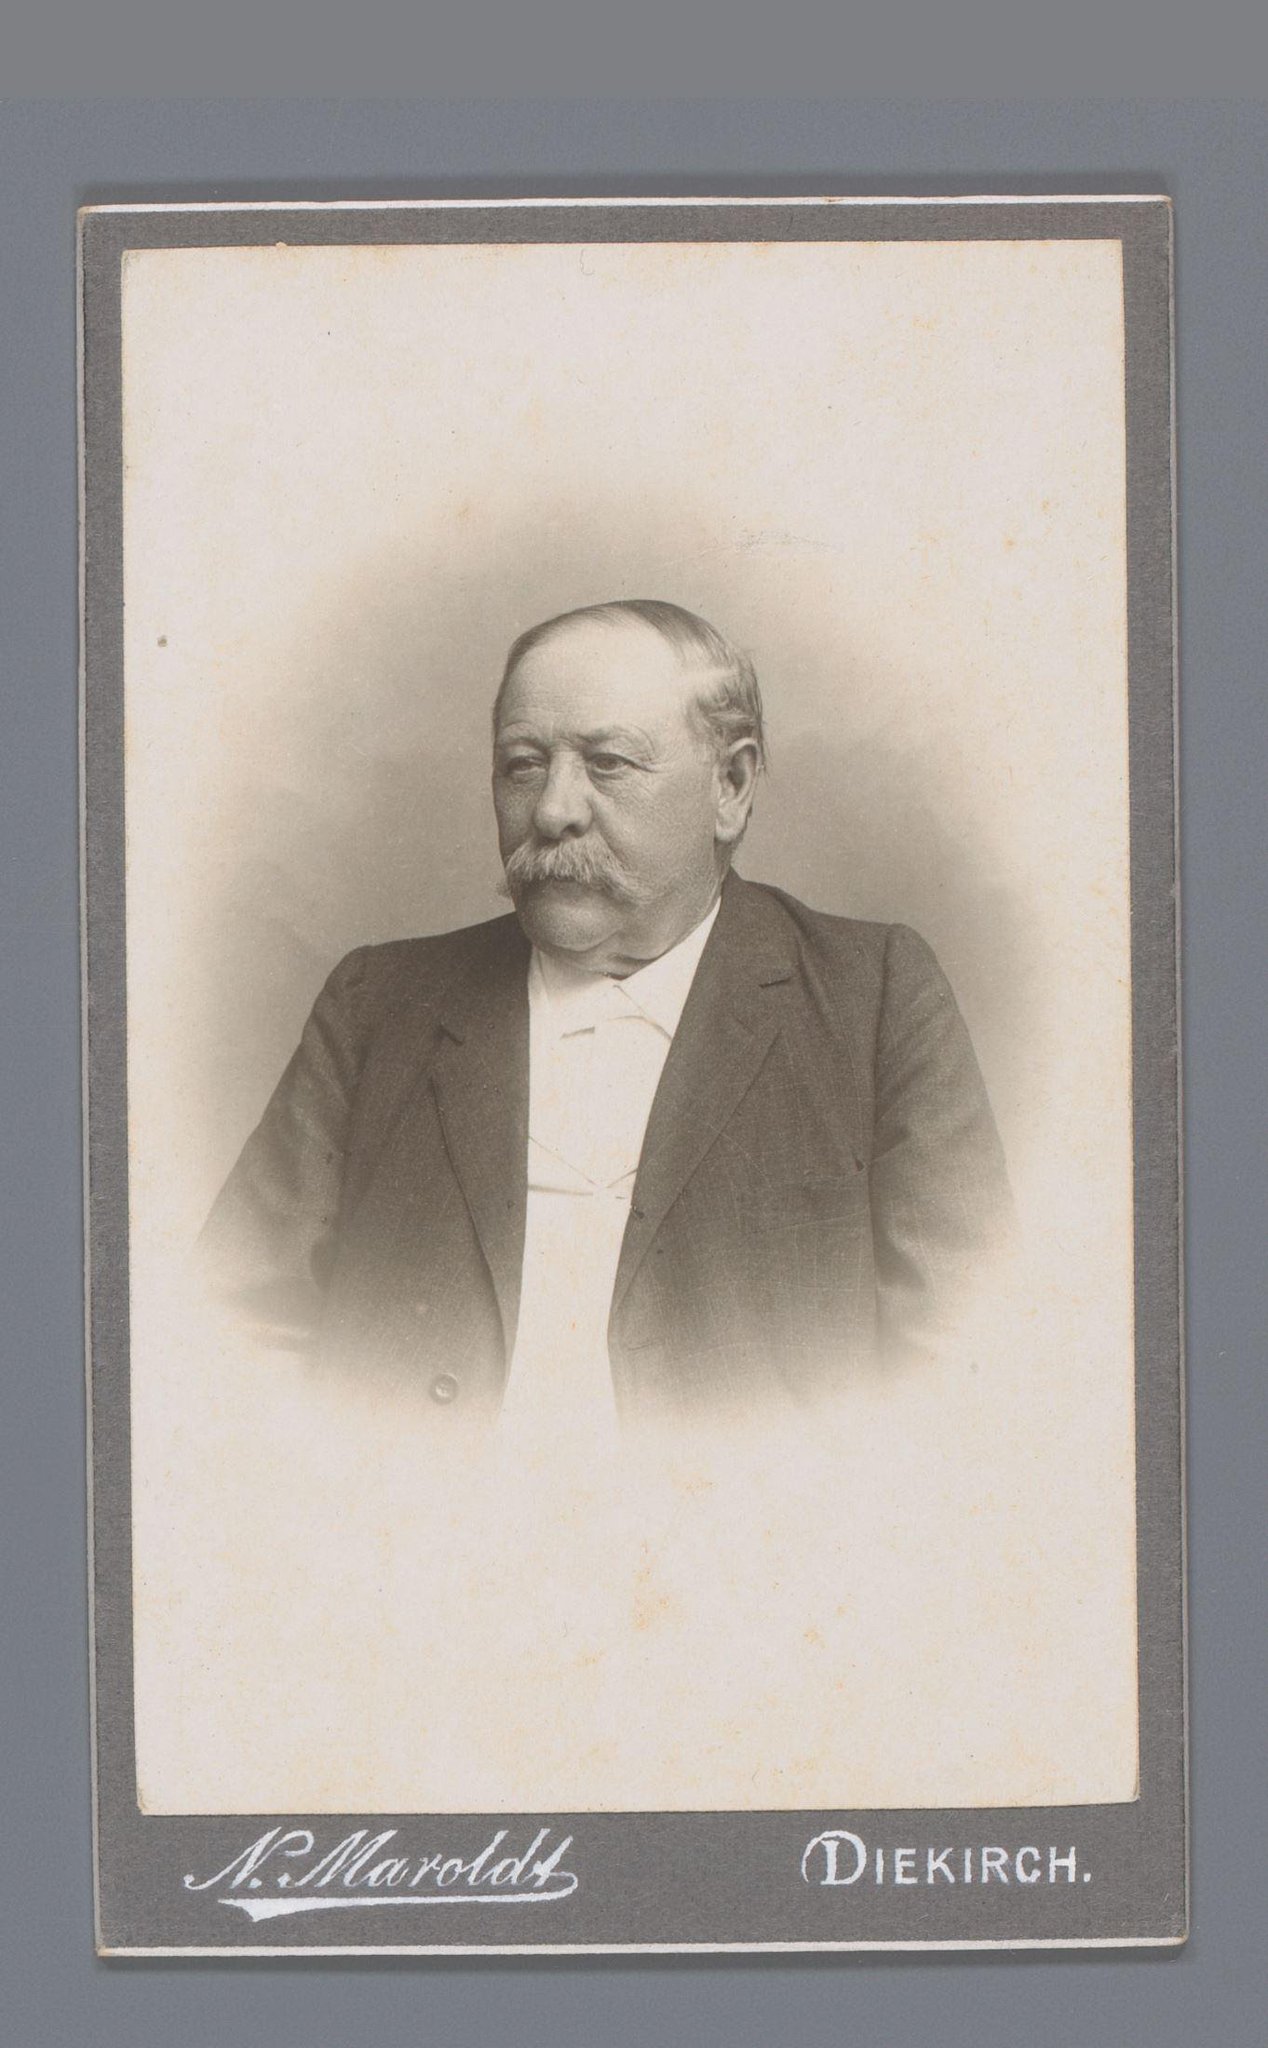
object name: carte de visite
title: Portret van een onbekende oudere man met snor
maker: nicolas maroldt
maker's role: fotograaf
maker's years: 1843-1906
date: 1890-1910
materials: cardboard, photographic support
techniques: daylight paper print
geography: diekirch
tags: historical persons, old man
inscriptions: inscription: ‘N. MAROLDT/ PHOTOGRAPHIE DE LA COUR/ DE SA MAJESTÉ LE ROI DES PAY-BAS/ GRAND-DUC DE LUXEMBOURG/ ET/ DE L.L. A.A. LE PRINCE ET LA PRINCESSE/ CHARLES D'ARENBERG./ DIEKIRCH./ Tous les clichés sont conservés.’